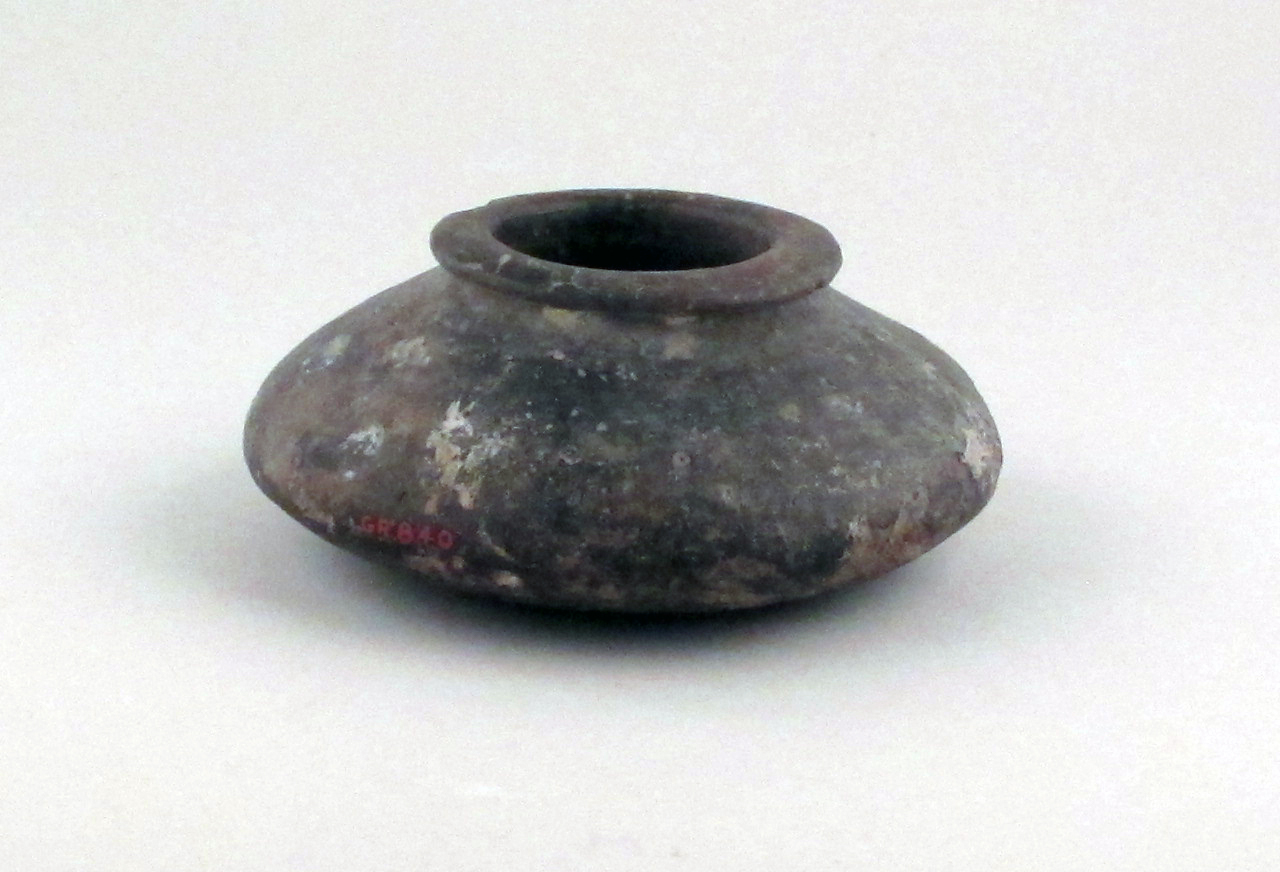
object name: vase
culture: etruscan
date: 600-550 BCE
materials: terracotta